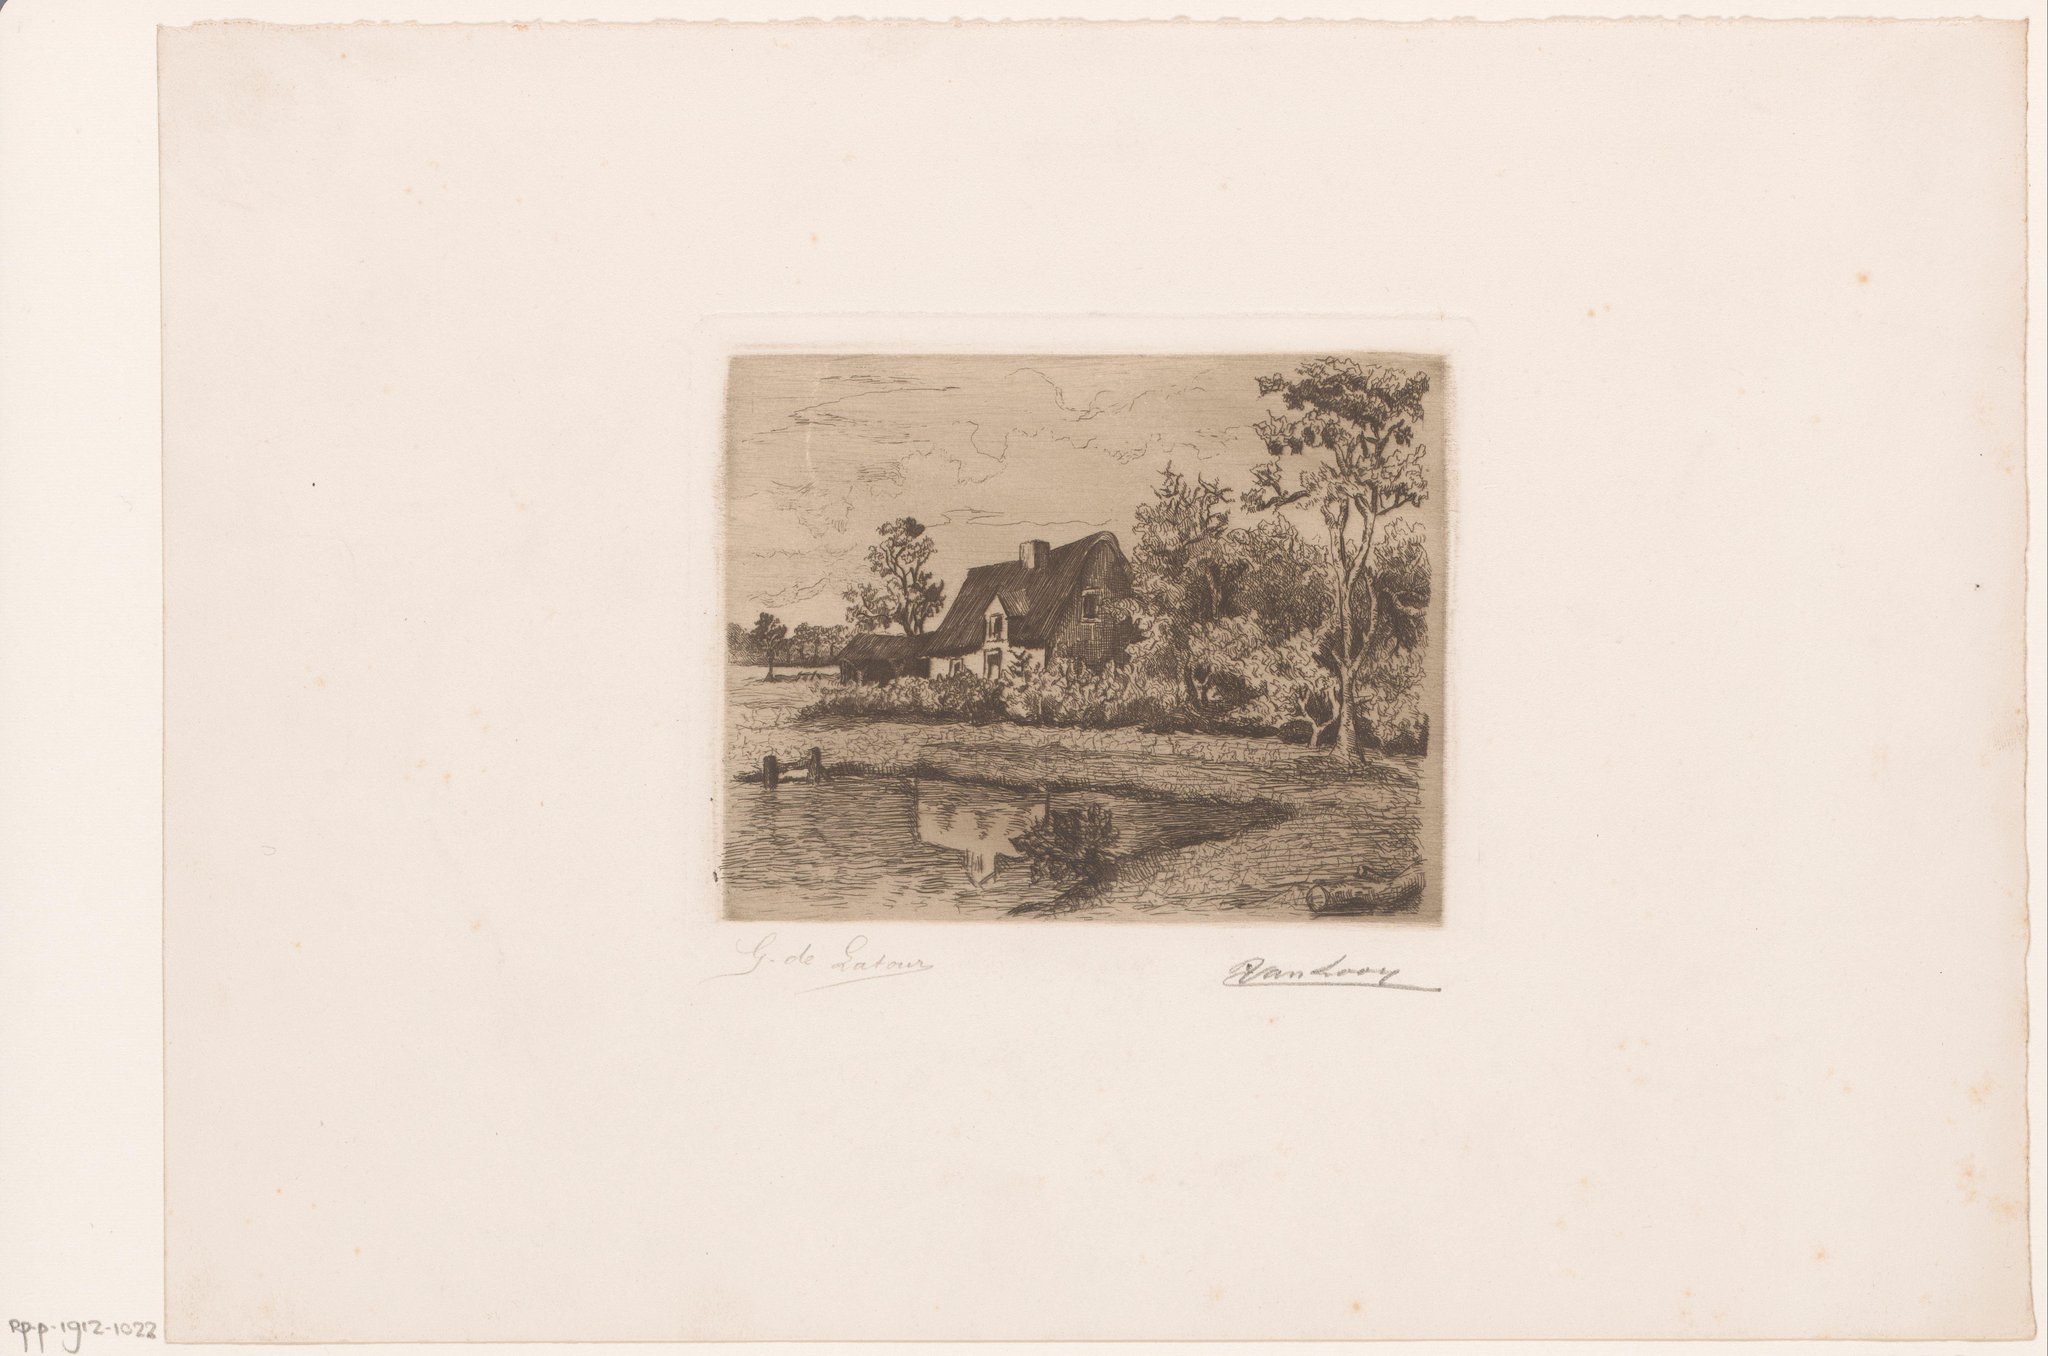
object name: print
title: Landschap met boerderij aan de rand van een water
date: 1881-1912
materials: paper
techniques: drypoint, etching, intaglio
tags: lake, farm or solitary house in landscape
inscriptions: collector's mark: Lugt 2228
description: Sterfdatum van de prentmaker is onbekend. Daarom is voor de bepaling van de rechten van dit object gebruik gemaakt van de verwervingsdatum Rijksmuseum Amsterdam.